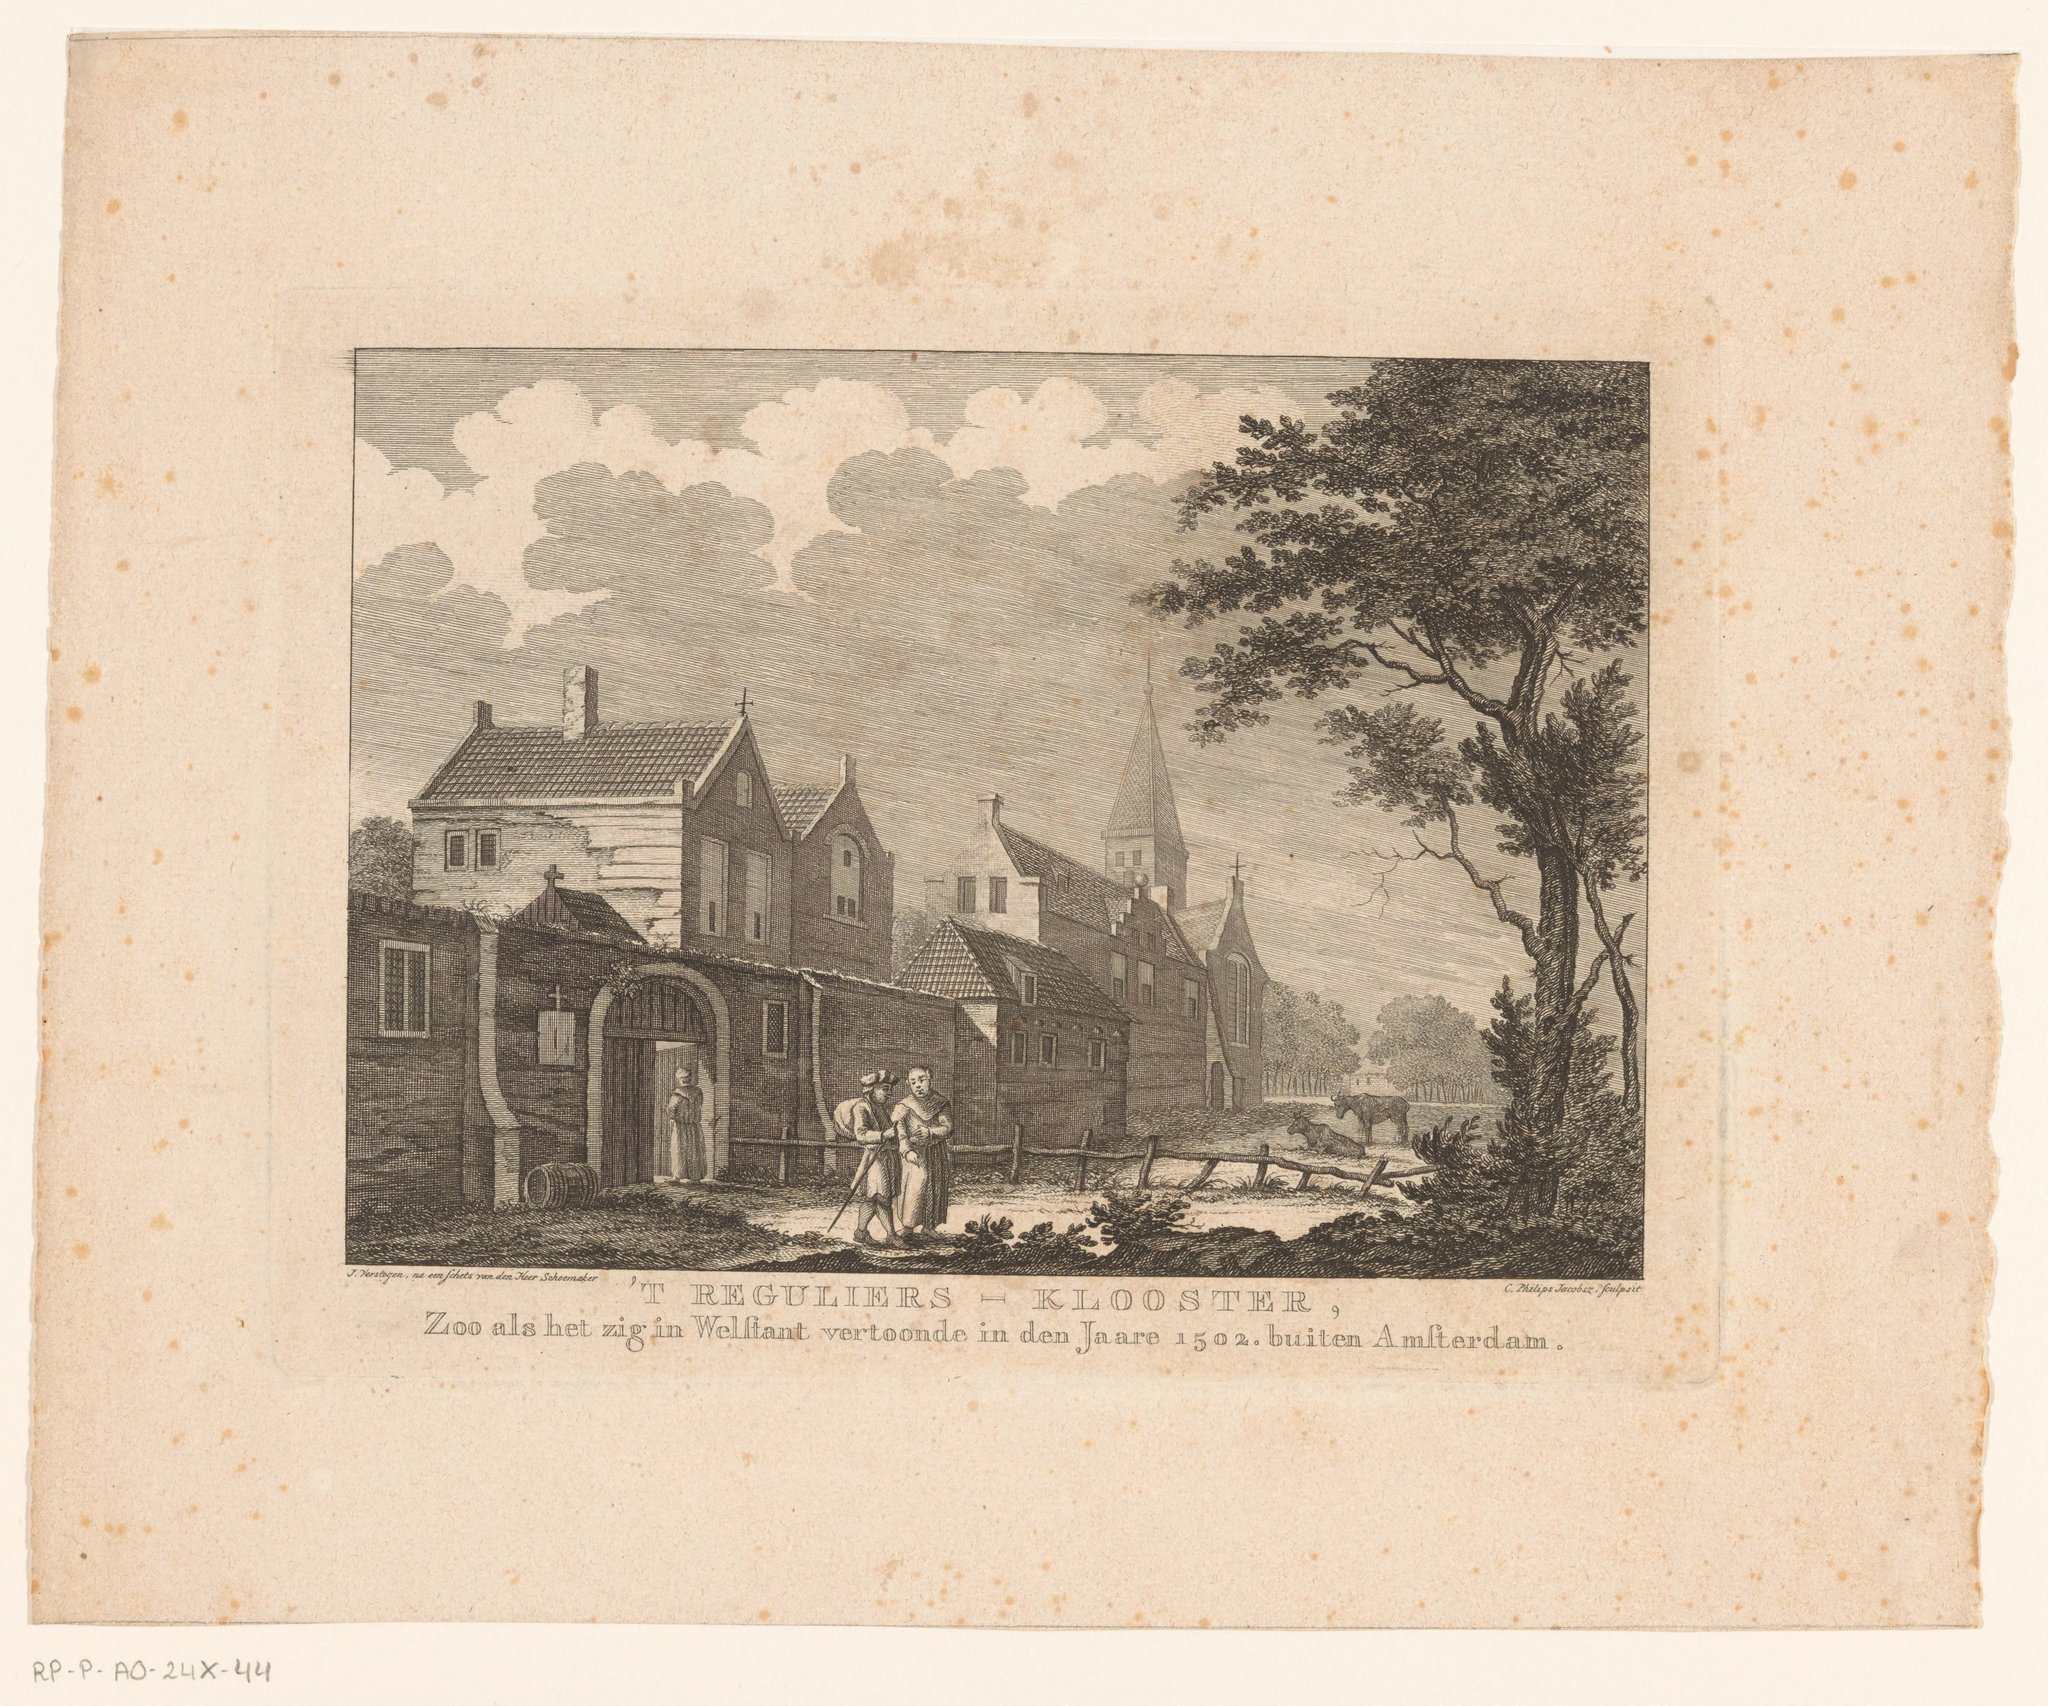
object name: print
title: 't Reguliers-Klooster, Zoo als het zig in Welstant vertoonde in den Jaare 1502. buiten Amsterdam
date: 1752-1789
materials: paper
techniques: engraving, etching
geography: amsterdam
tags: abbey, monastery, convent ~ roman catholic church, monk(s), friar(s)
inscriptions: collector's mark: Lugt 2233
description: Deze prent is ook ingebonden in enkele exemplaren van: Wagenaar, Jan. Amsterdam, in zyne opkomst, aanwas, geschiedenissen (…). 3 delen [folio-uitgave]. Amsterdam: Isaak Tirion en Yntema & Tieboel, 1760-1767, dl. 2 (Isaak Tirion, 1765). Komt echter niet voor in de lijst met in te binden prenten van deze uitgave (te vinden in dl. 3) - en is er dus ook niet voor bedoeld. Zie ook RP-P-AO-24X-43-1, RP-P-AO-24X-43-2 en RP-P-AO-24X-45.